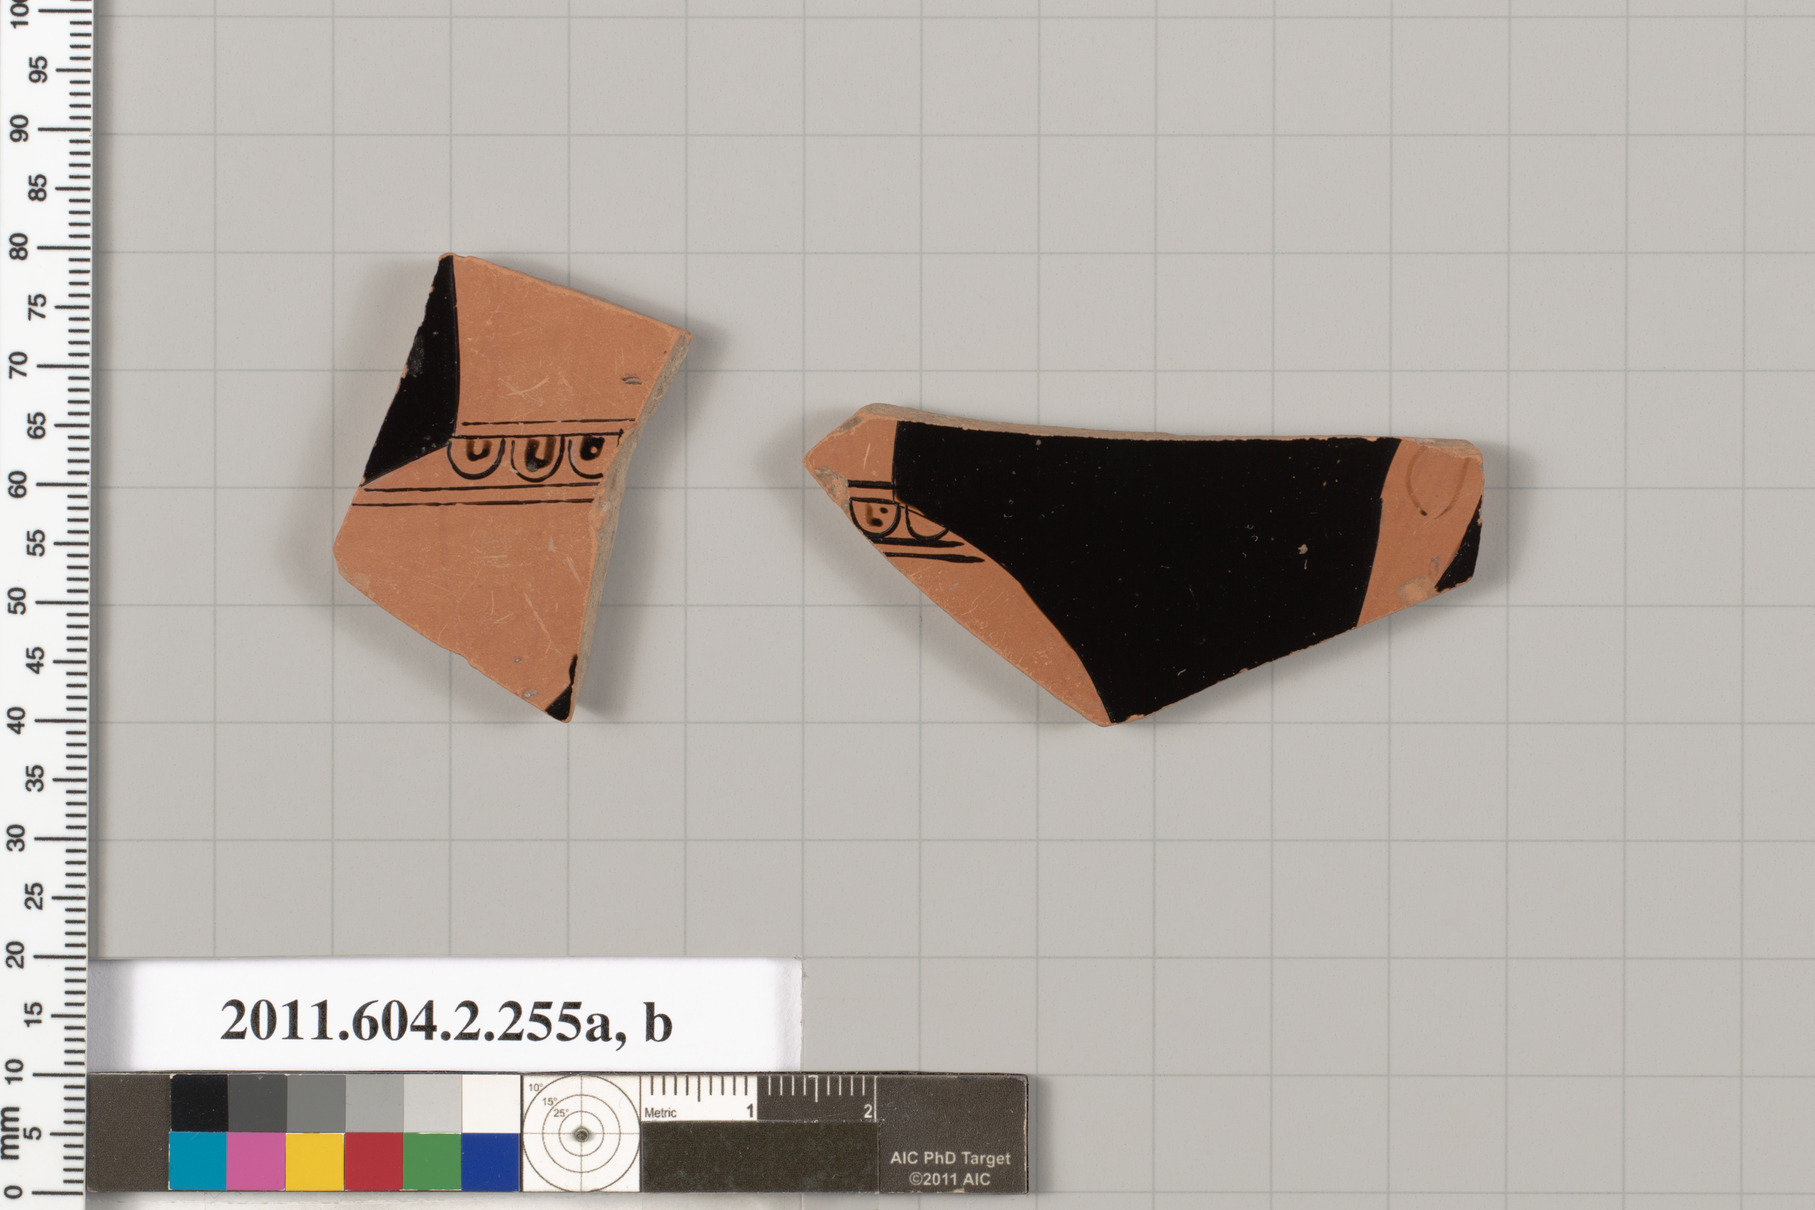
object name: stamnos fragment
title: Terracotta fragments of a stamnos (jar)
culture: greek, attic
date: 500-476 BCE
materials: terracotta